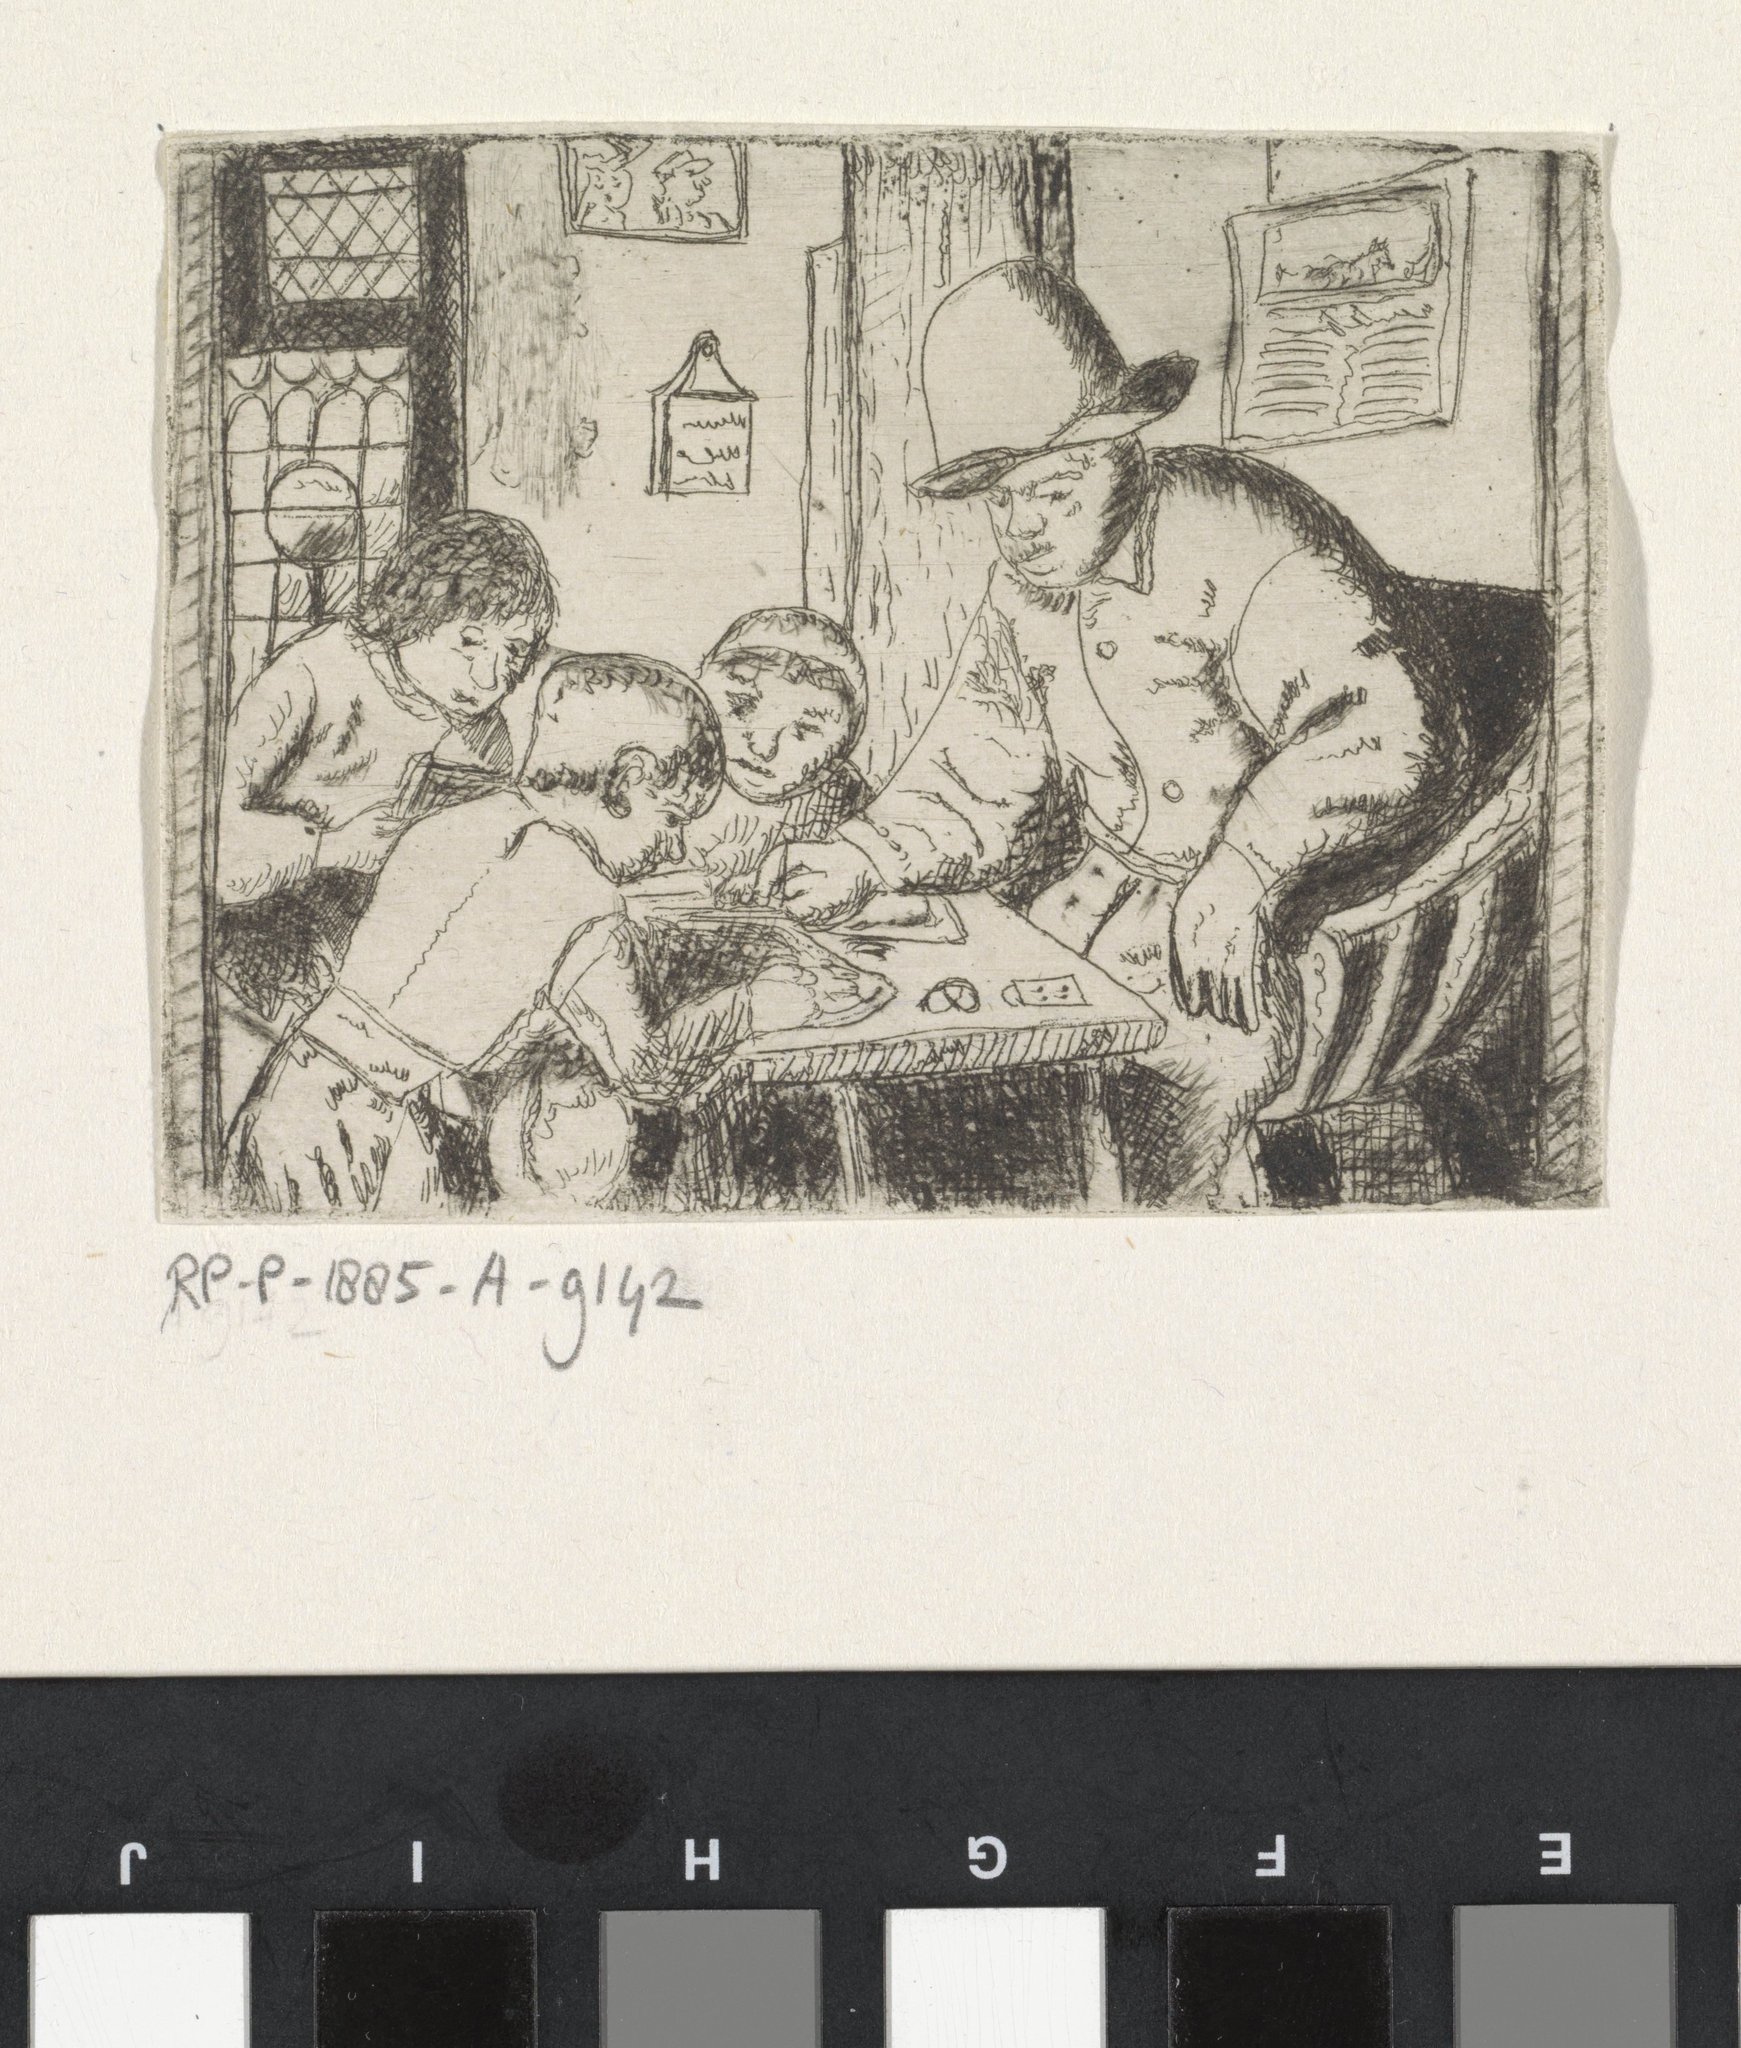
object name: print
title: Schoolmeester met drie leerlingen bij tafel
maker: Anonymous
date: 1671-1771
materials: paper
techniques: etching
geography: netherlands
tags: teacher and pupil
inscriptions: collector's mark: Lugt 2228